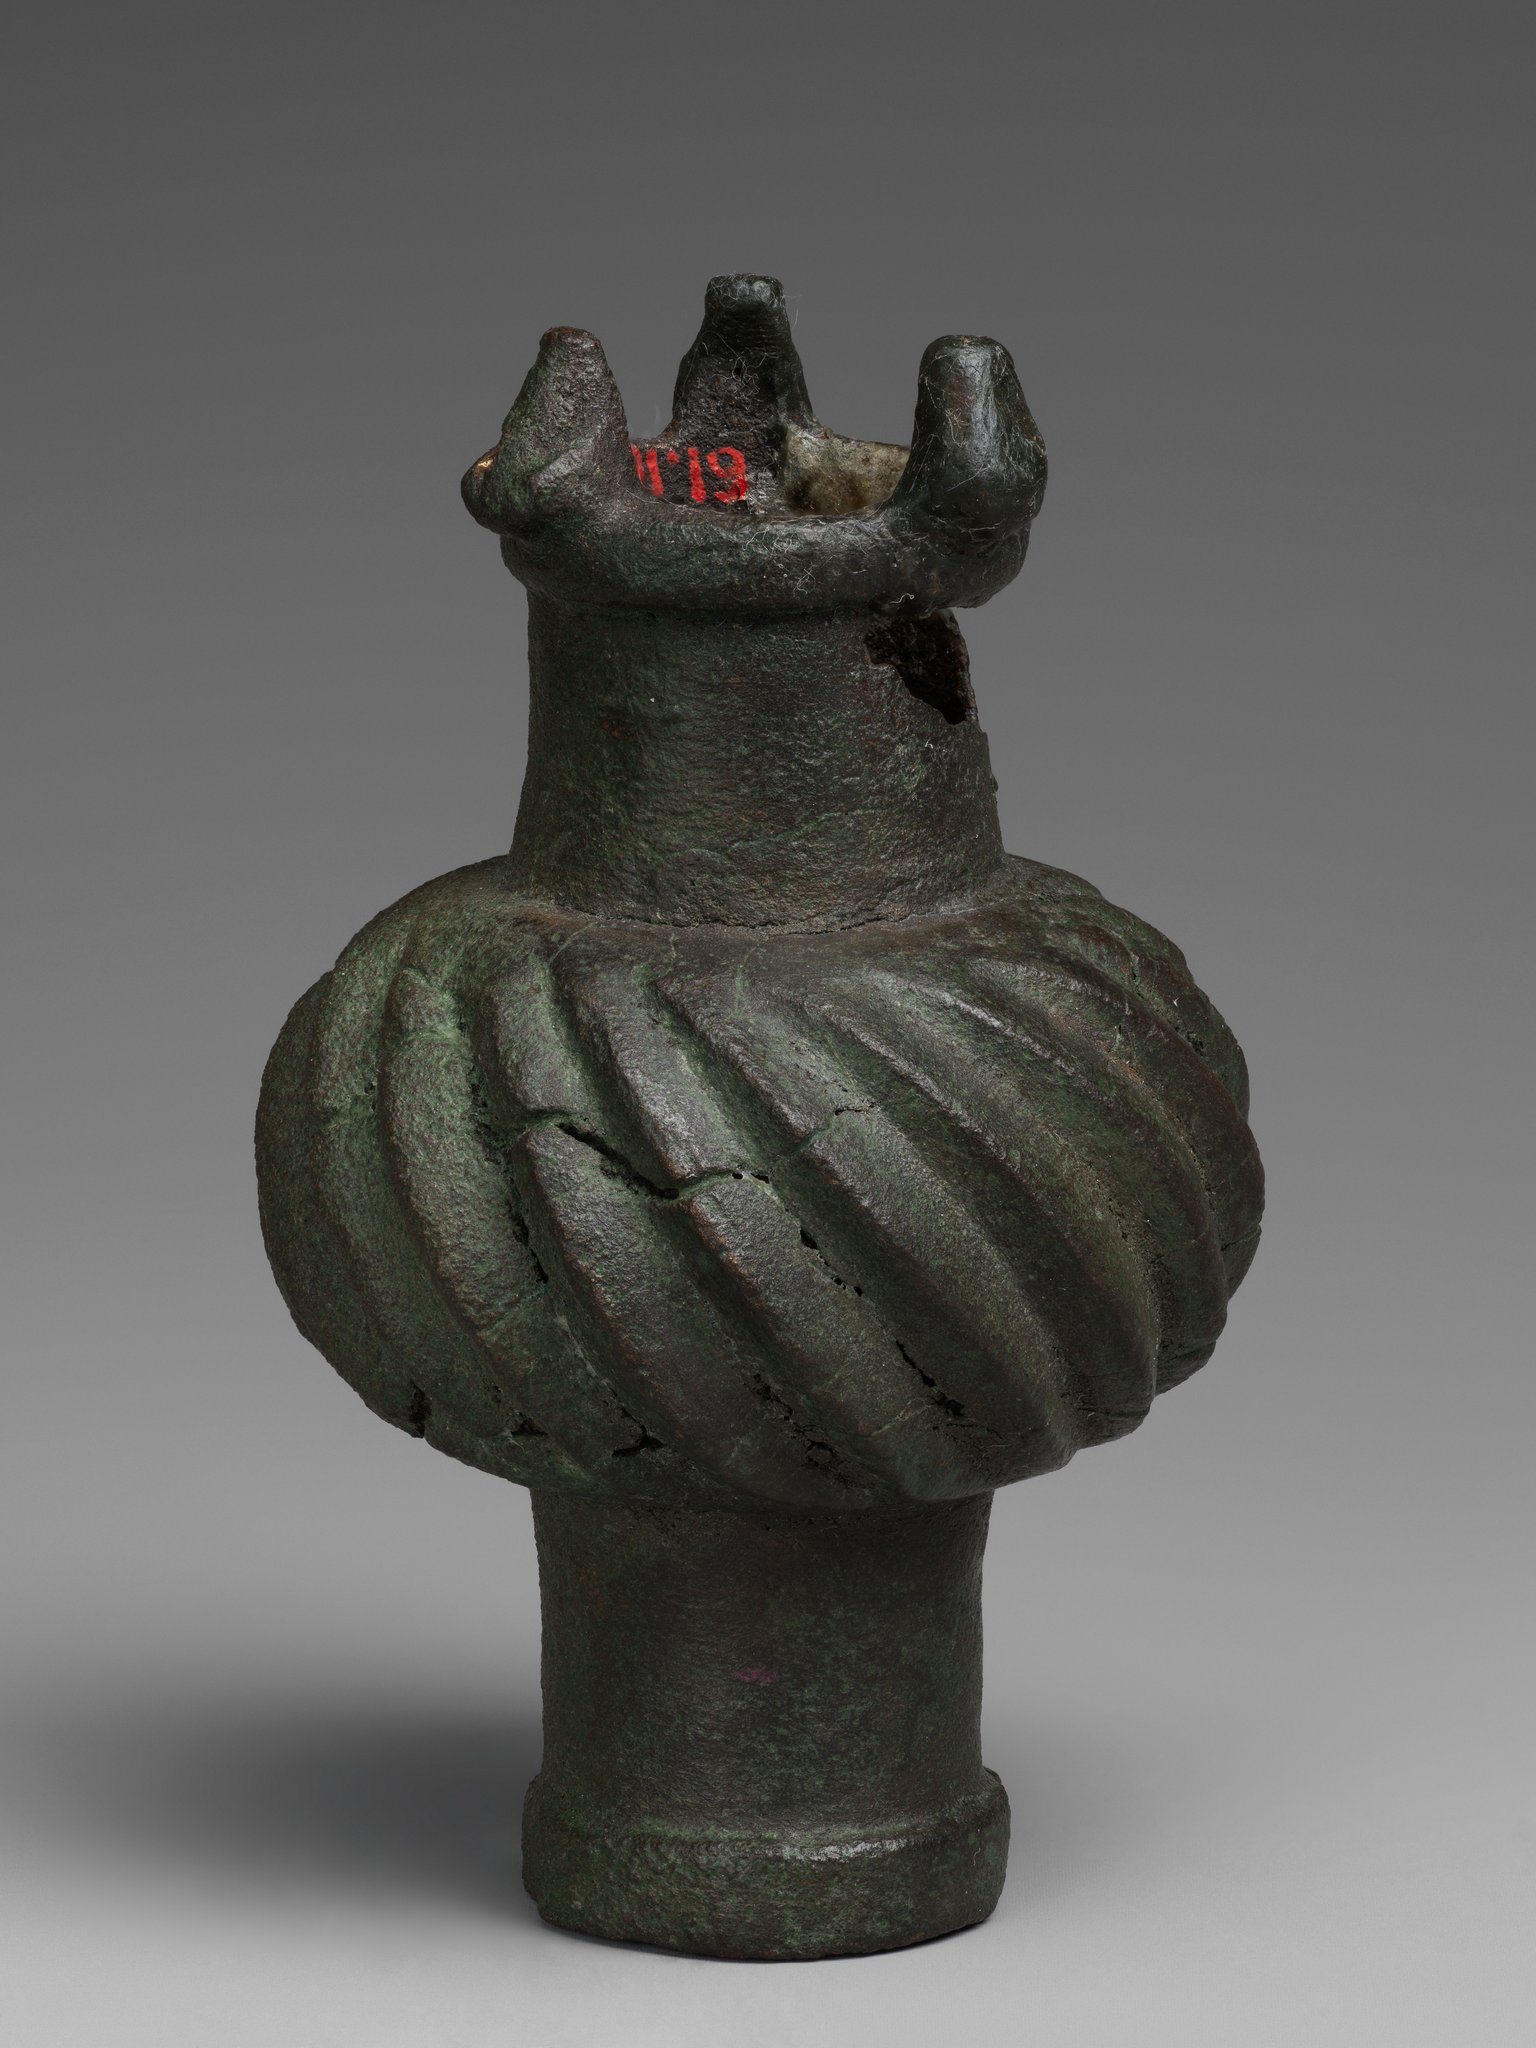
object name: mace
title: Mace head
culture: iranian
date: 900-801 BCE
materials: bronze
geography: iran